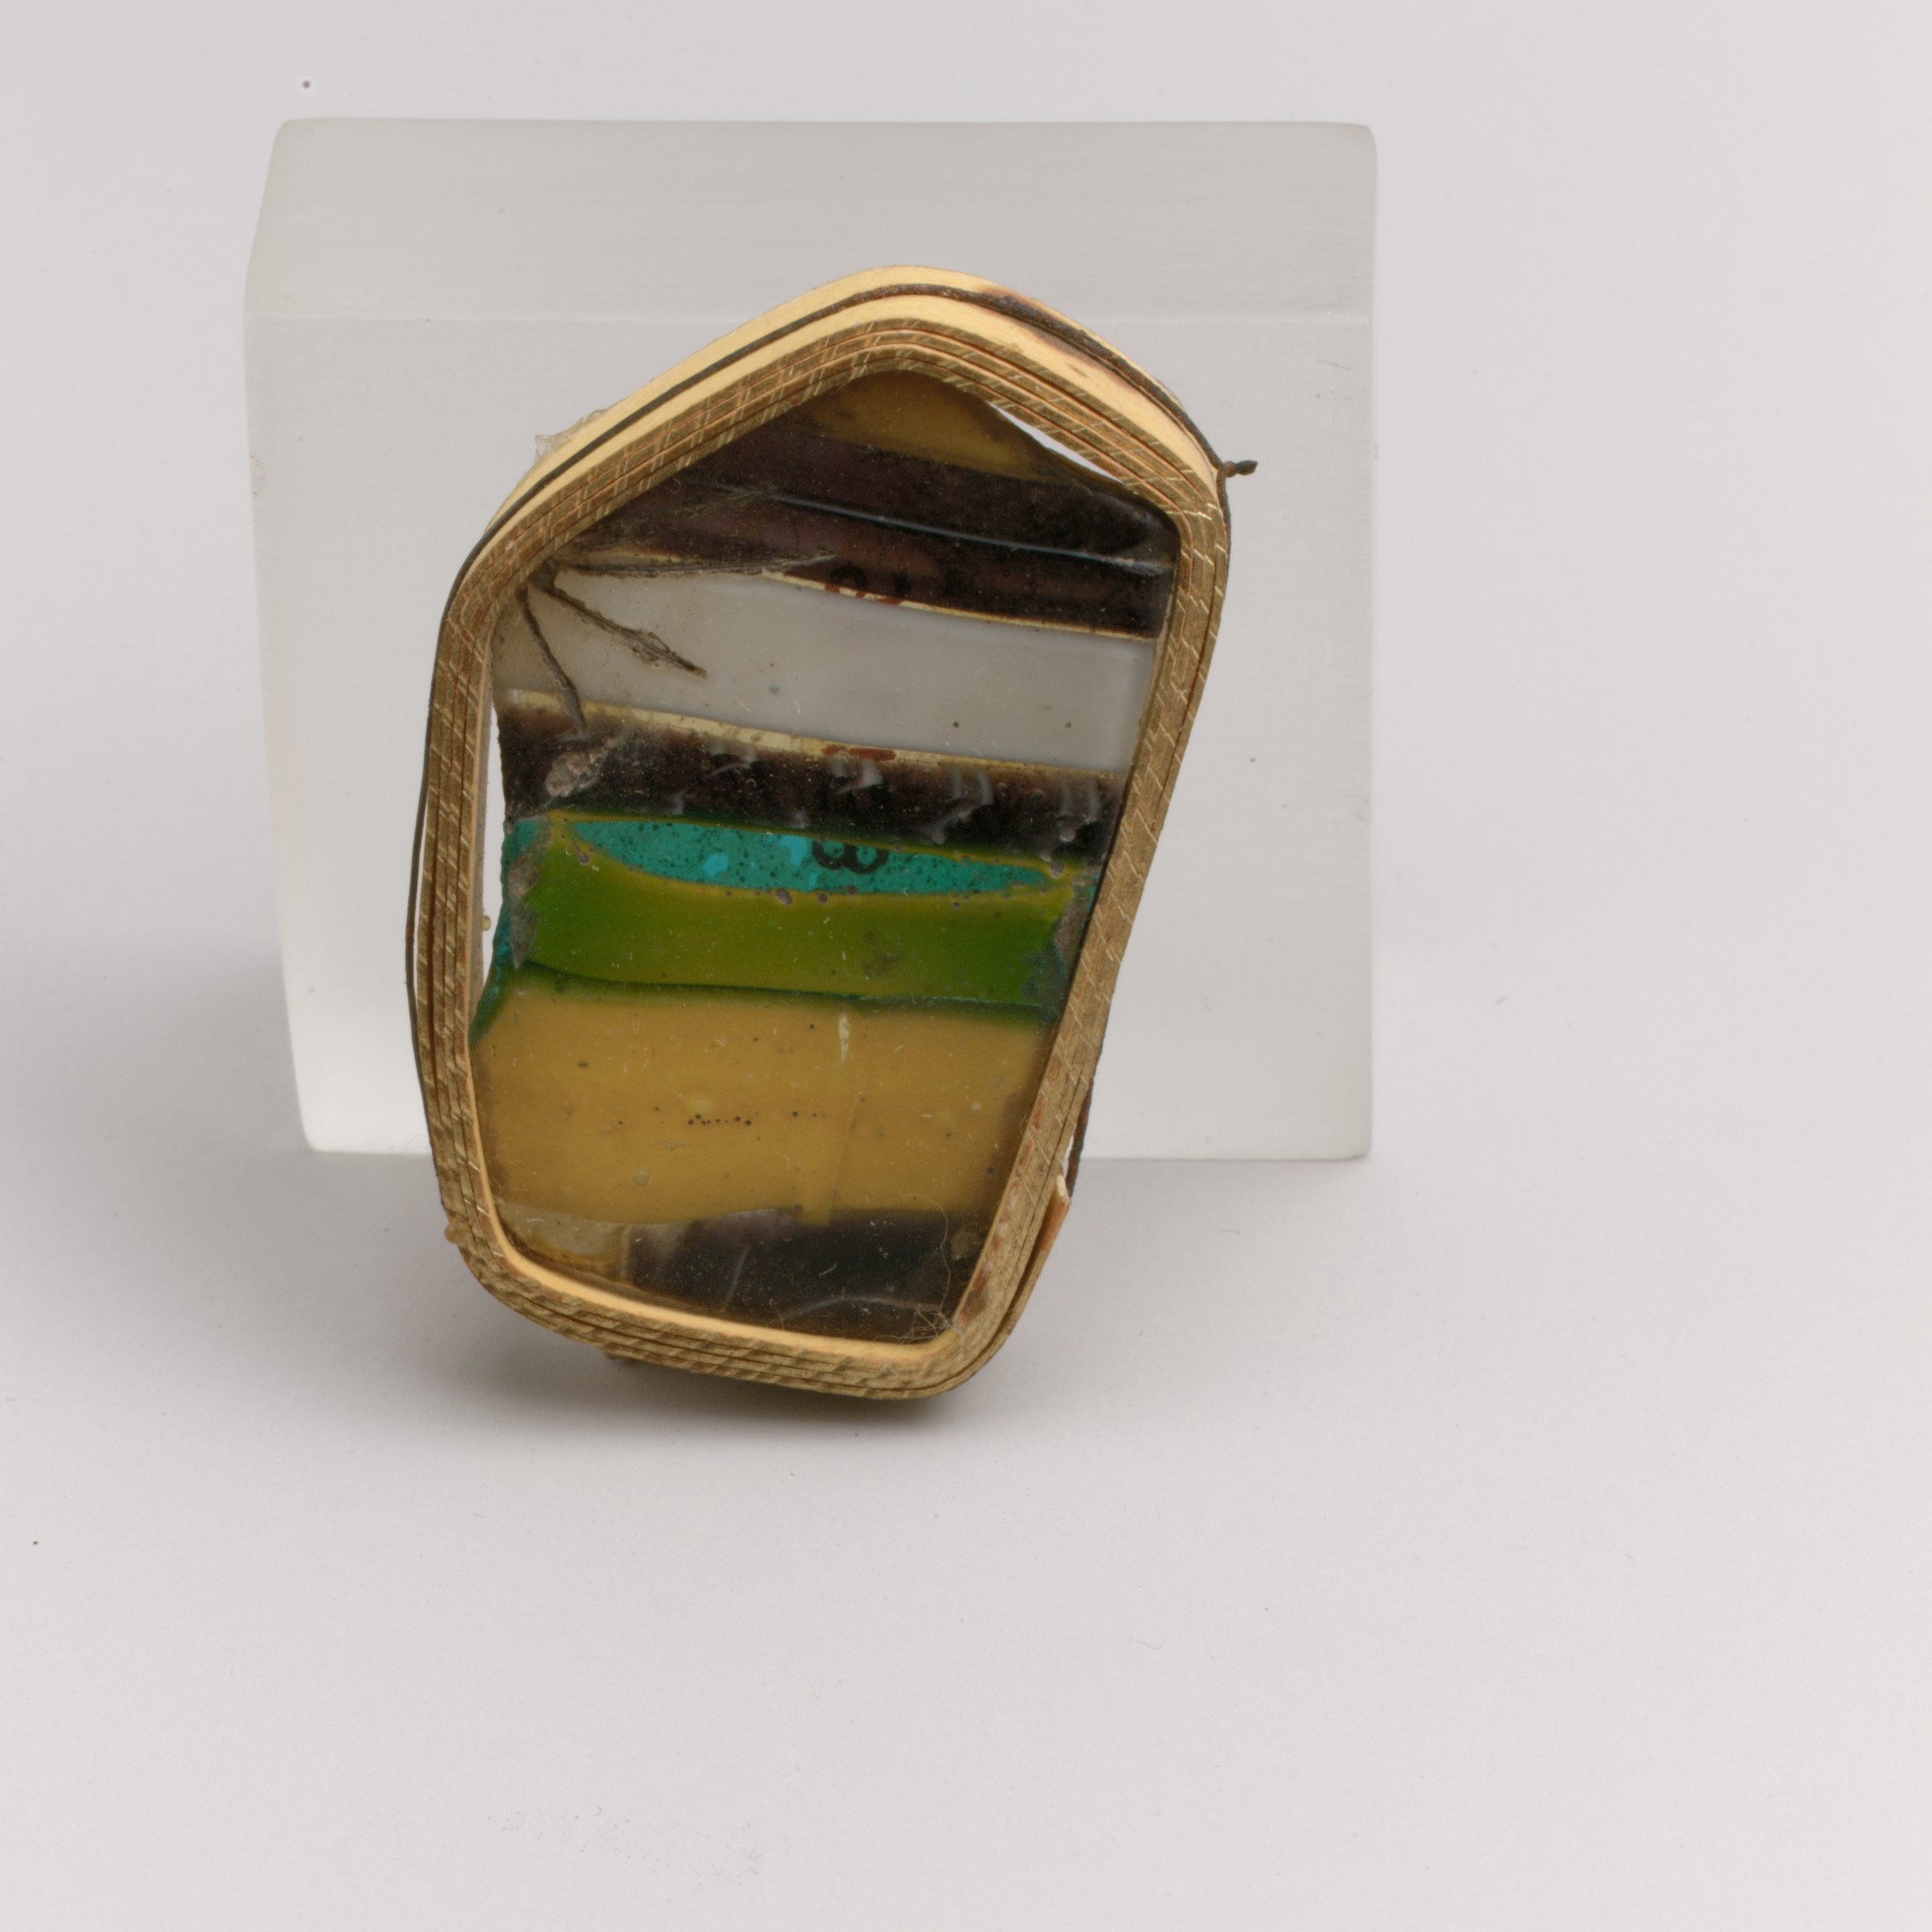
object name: fragment, striped mosaic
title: Glass striped mosaic fragment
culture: roman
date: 34 BCE-33 CE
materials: glass